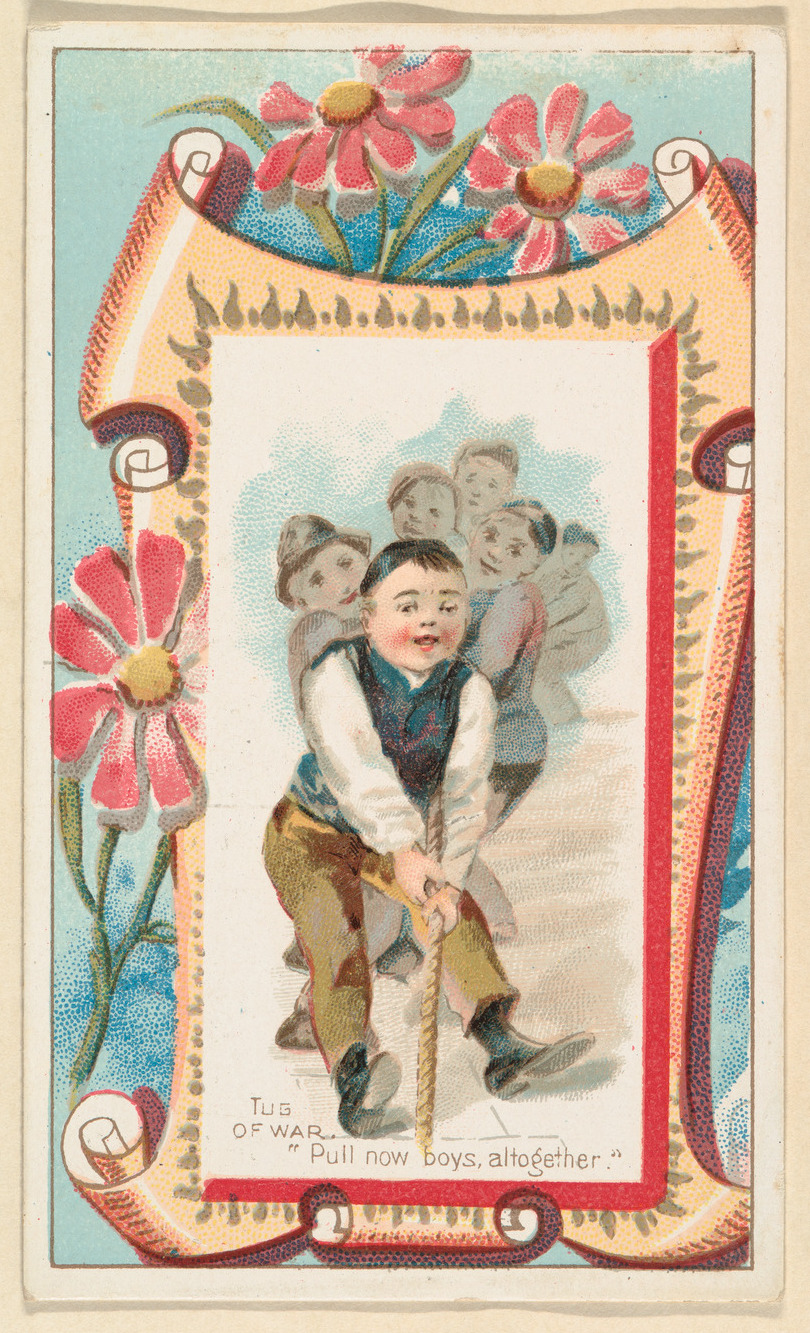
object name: print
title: Tug of War, "Pull now boys, altogether," from the Terrors of America set (N136) issued by Duke Sons & Co. to promote Honest Long Cut Tobacco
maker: w. duke, sons & co.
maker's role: publisher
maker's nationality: american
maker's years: 1870-1920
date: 1888-1889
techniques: color lithograph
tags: boys,playing